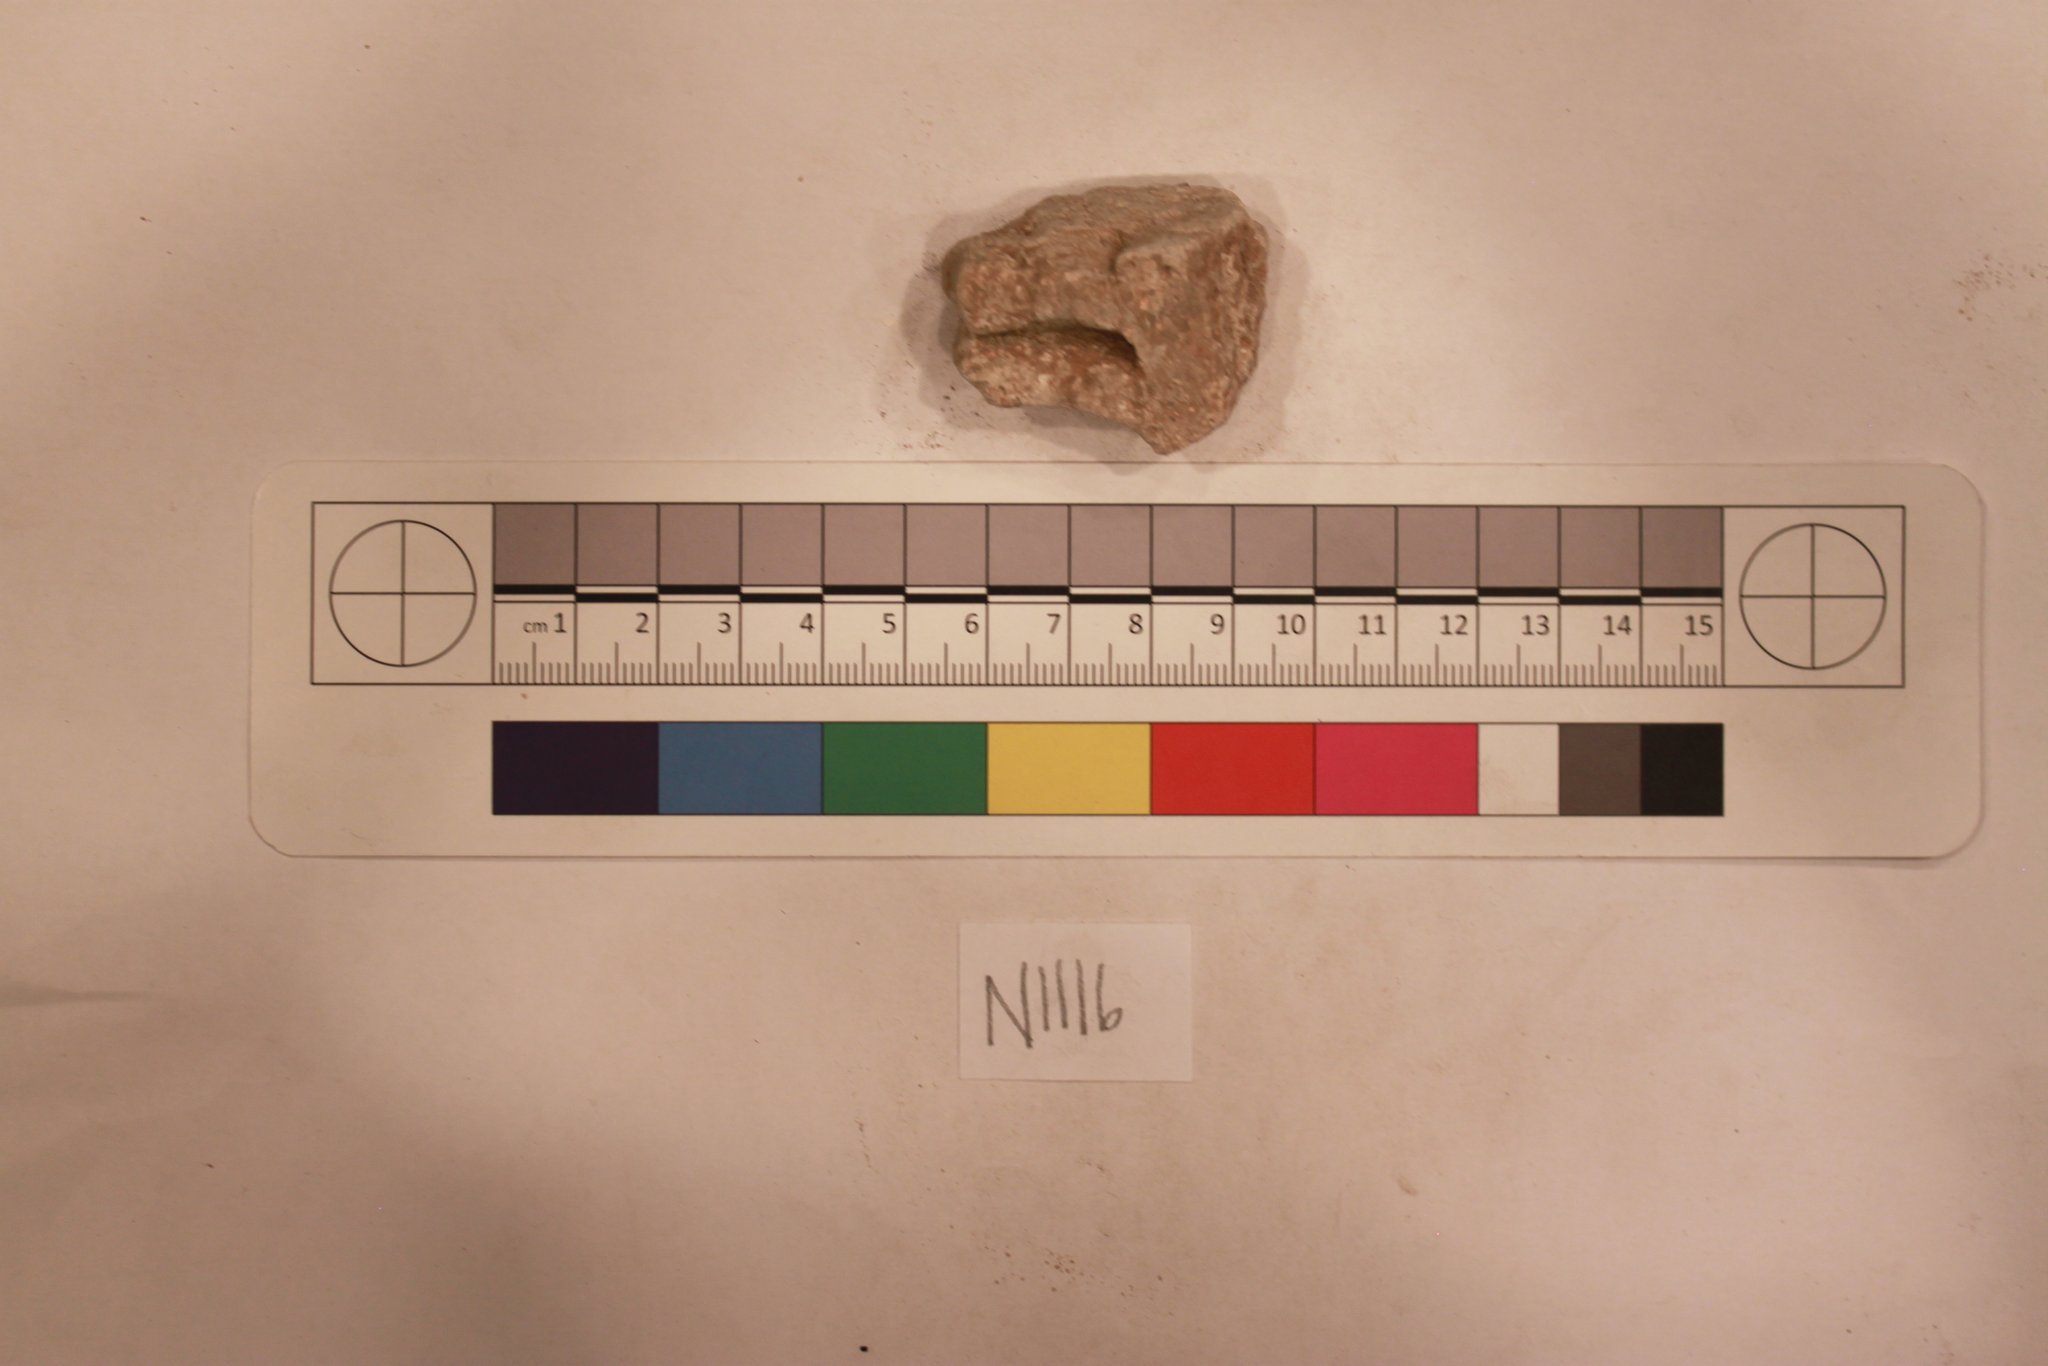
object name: fragment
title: Stucco Fragment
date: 701-1200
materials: plaster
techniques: carving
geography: iran